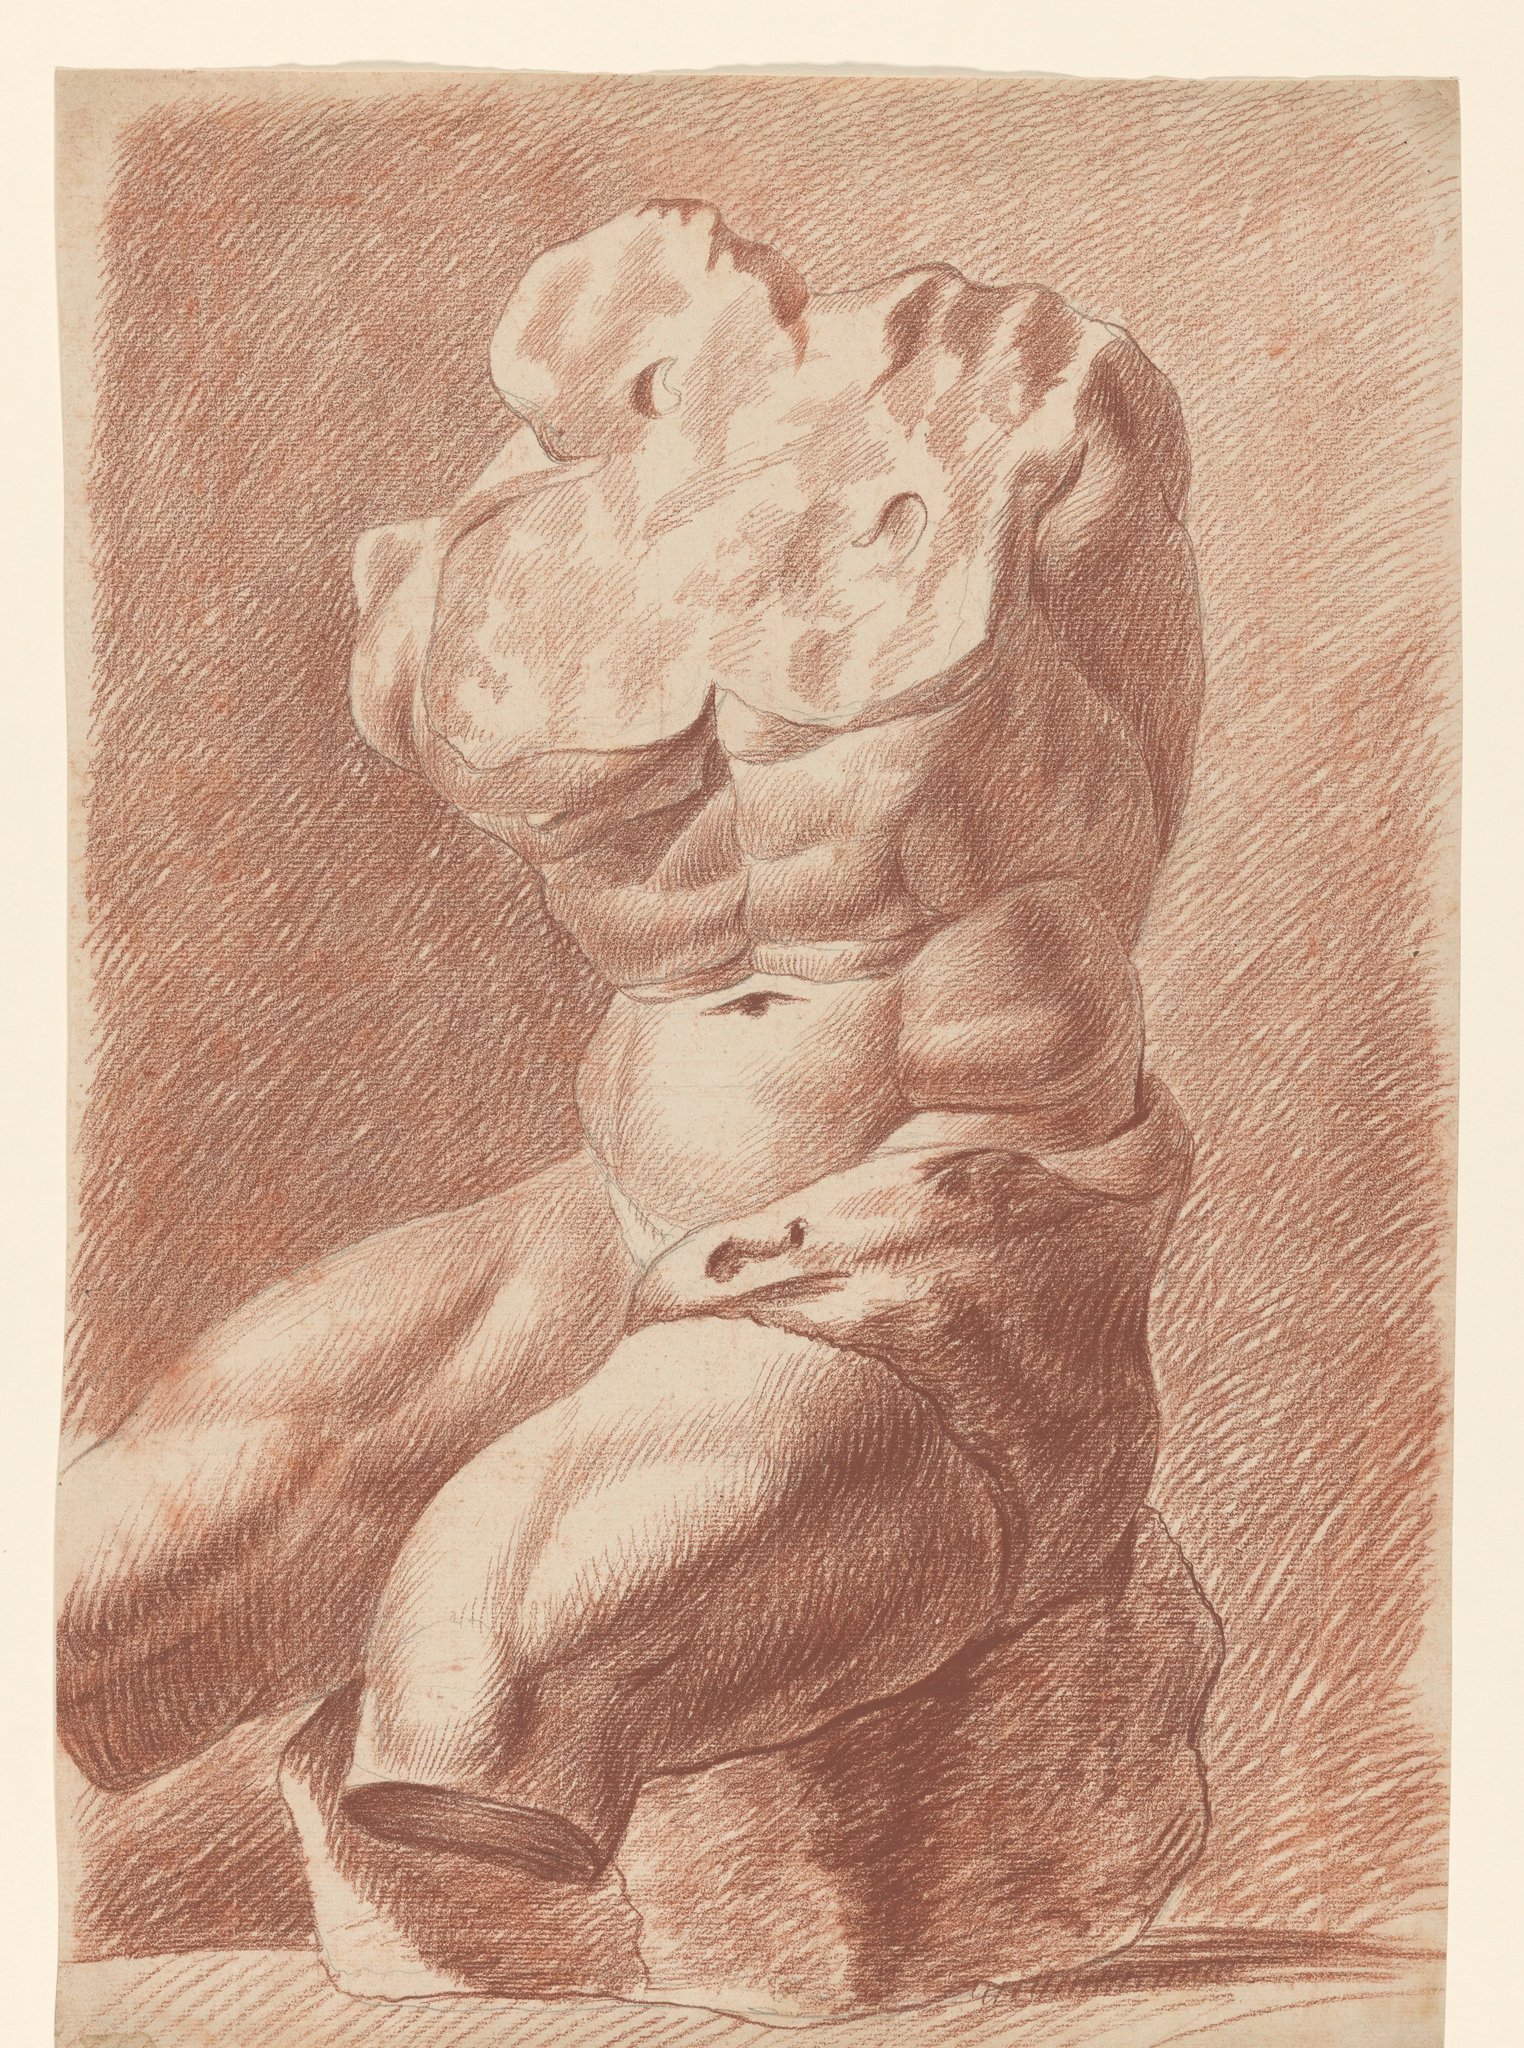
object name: drawing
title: Academiestudie: torso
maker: arnoldus dirk felix tavenraat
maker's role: draughtsman, print maker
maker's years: 1846-1899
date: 1856-1899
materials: chalk, paper, pencil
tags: piece of sculpture, reproduction of a piece of sculpture